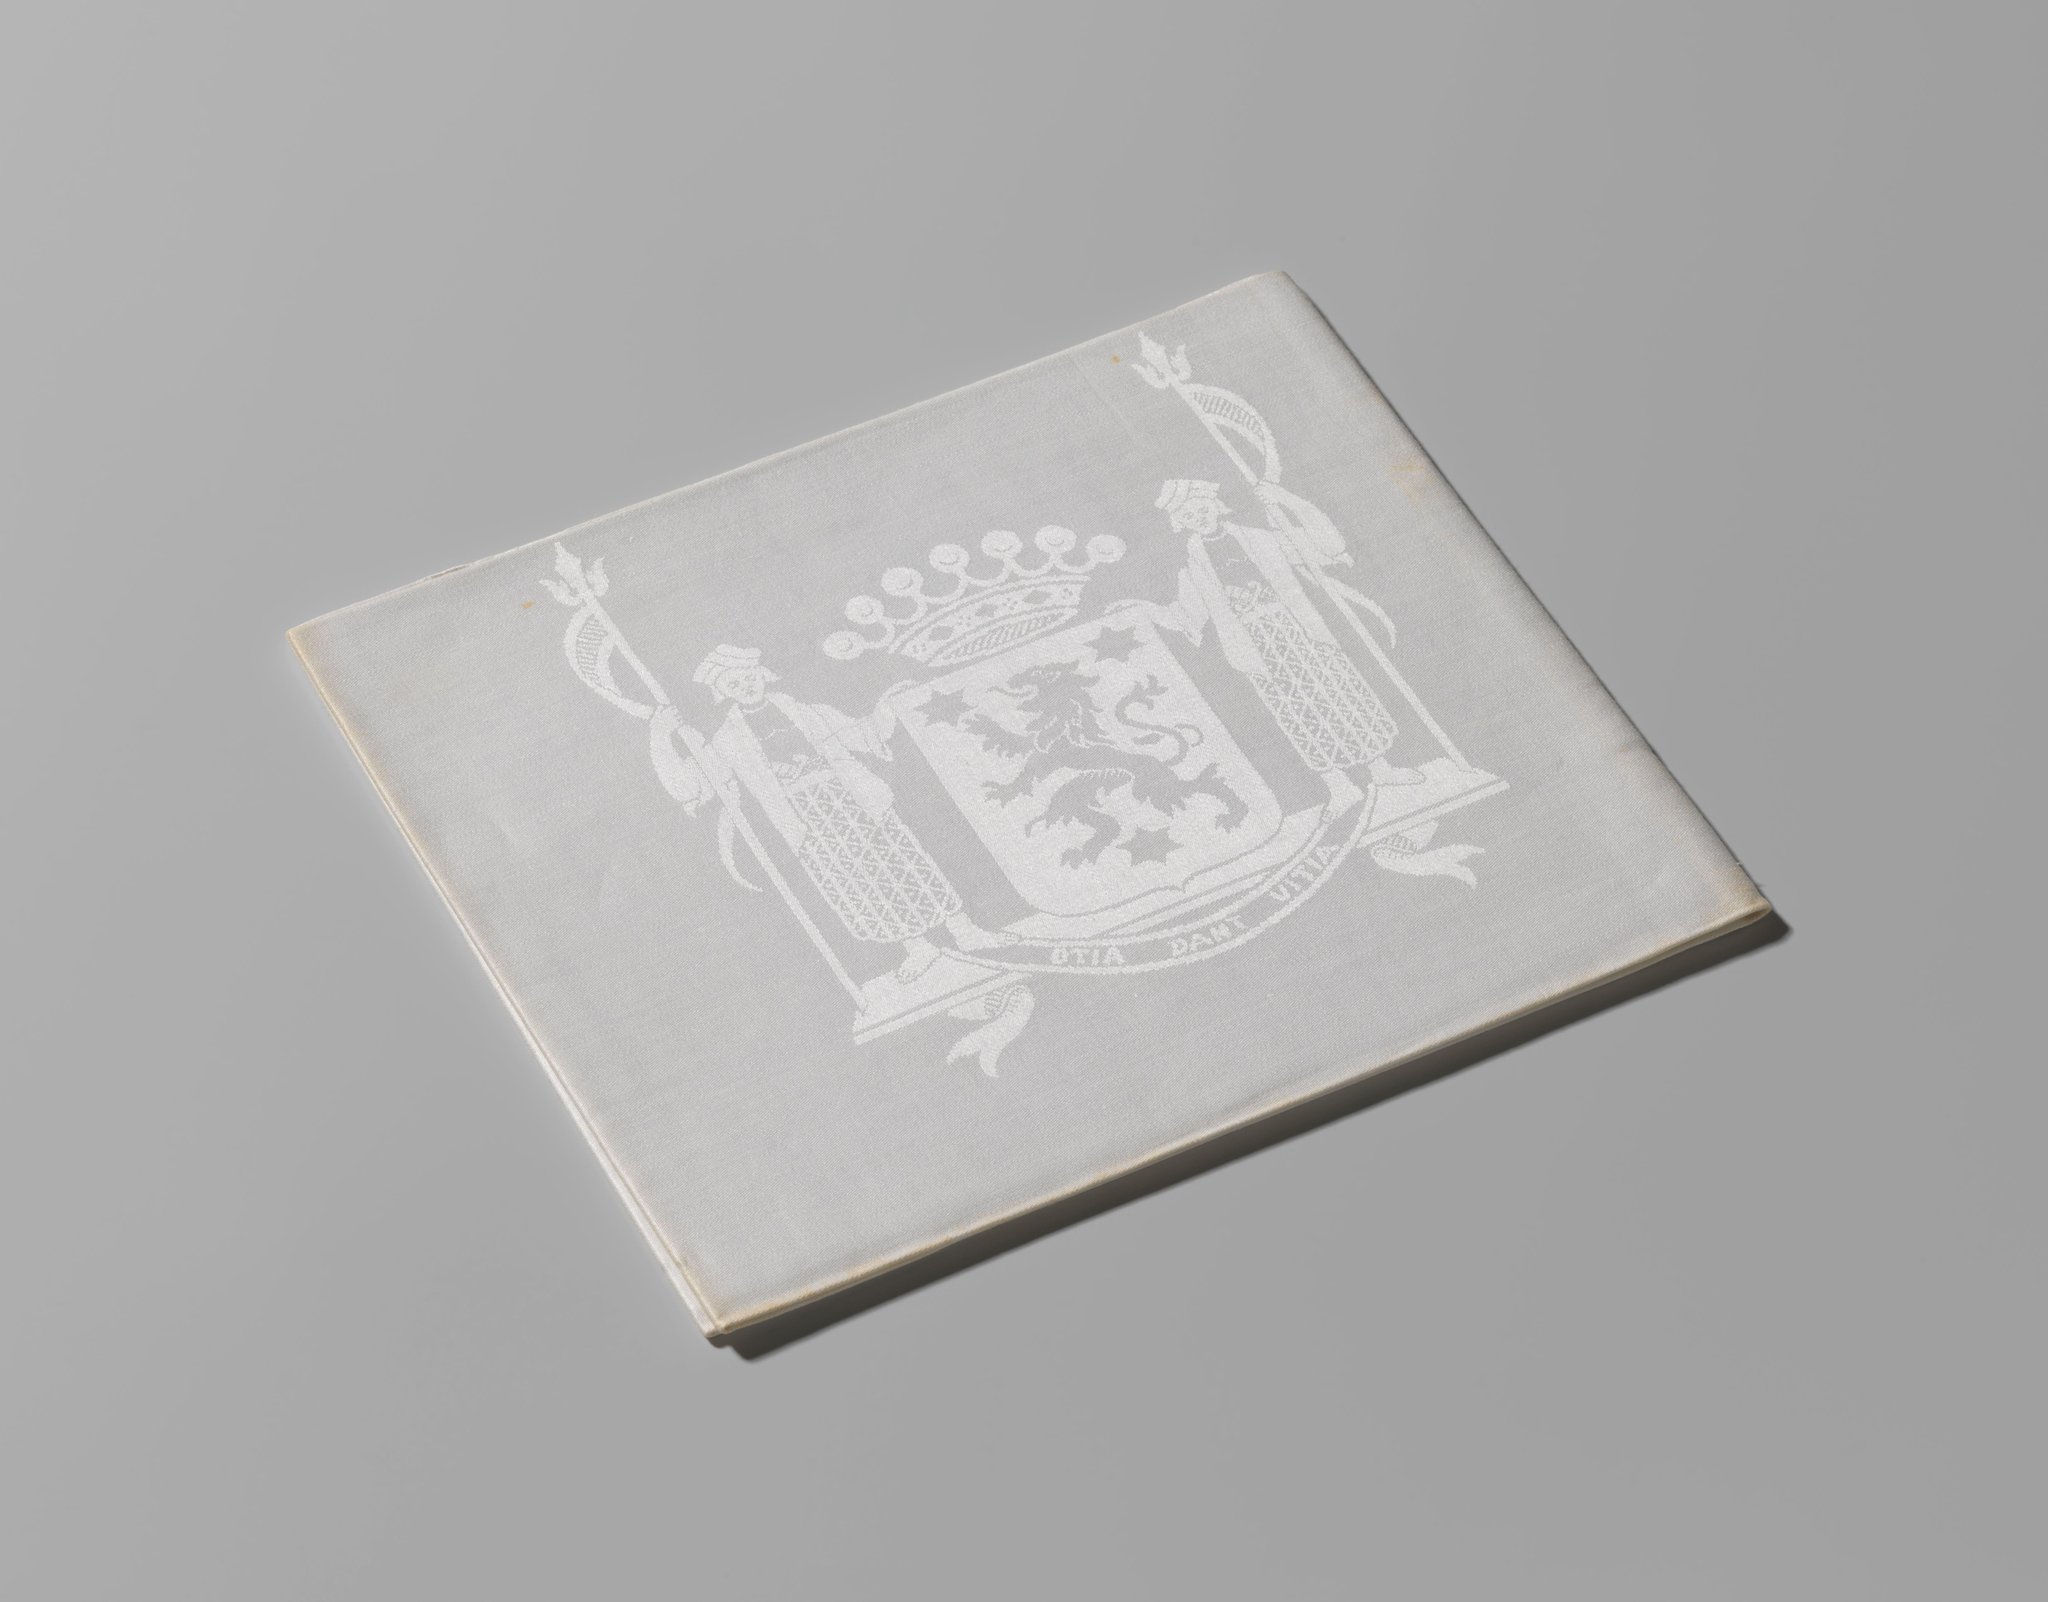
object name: napkin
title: Servet van wit linnendamast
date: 1852-1889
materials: linen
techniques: damask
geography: veghel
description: Wit linnen damasten servet met eikentakken en het wapen van de baronnen Baud. Gemerkt BvH.